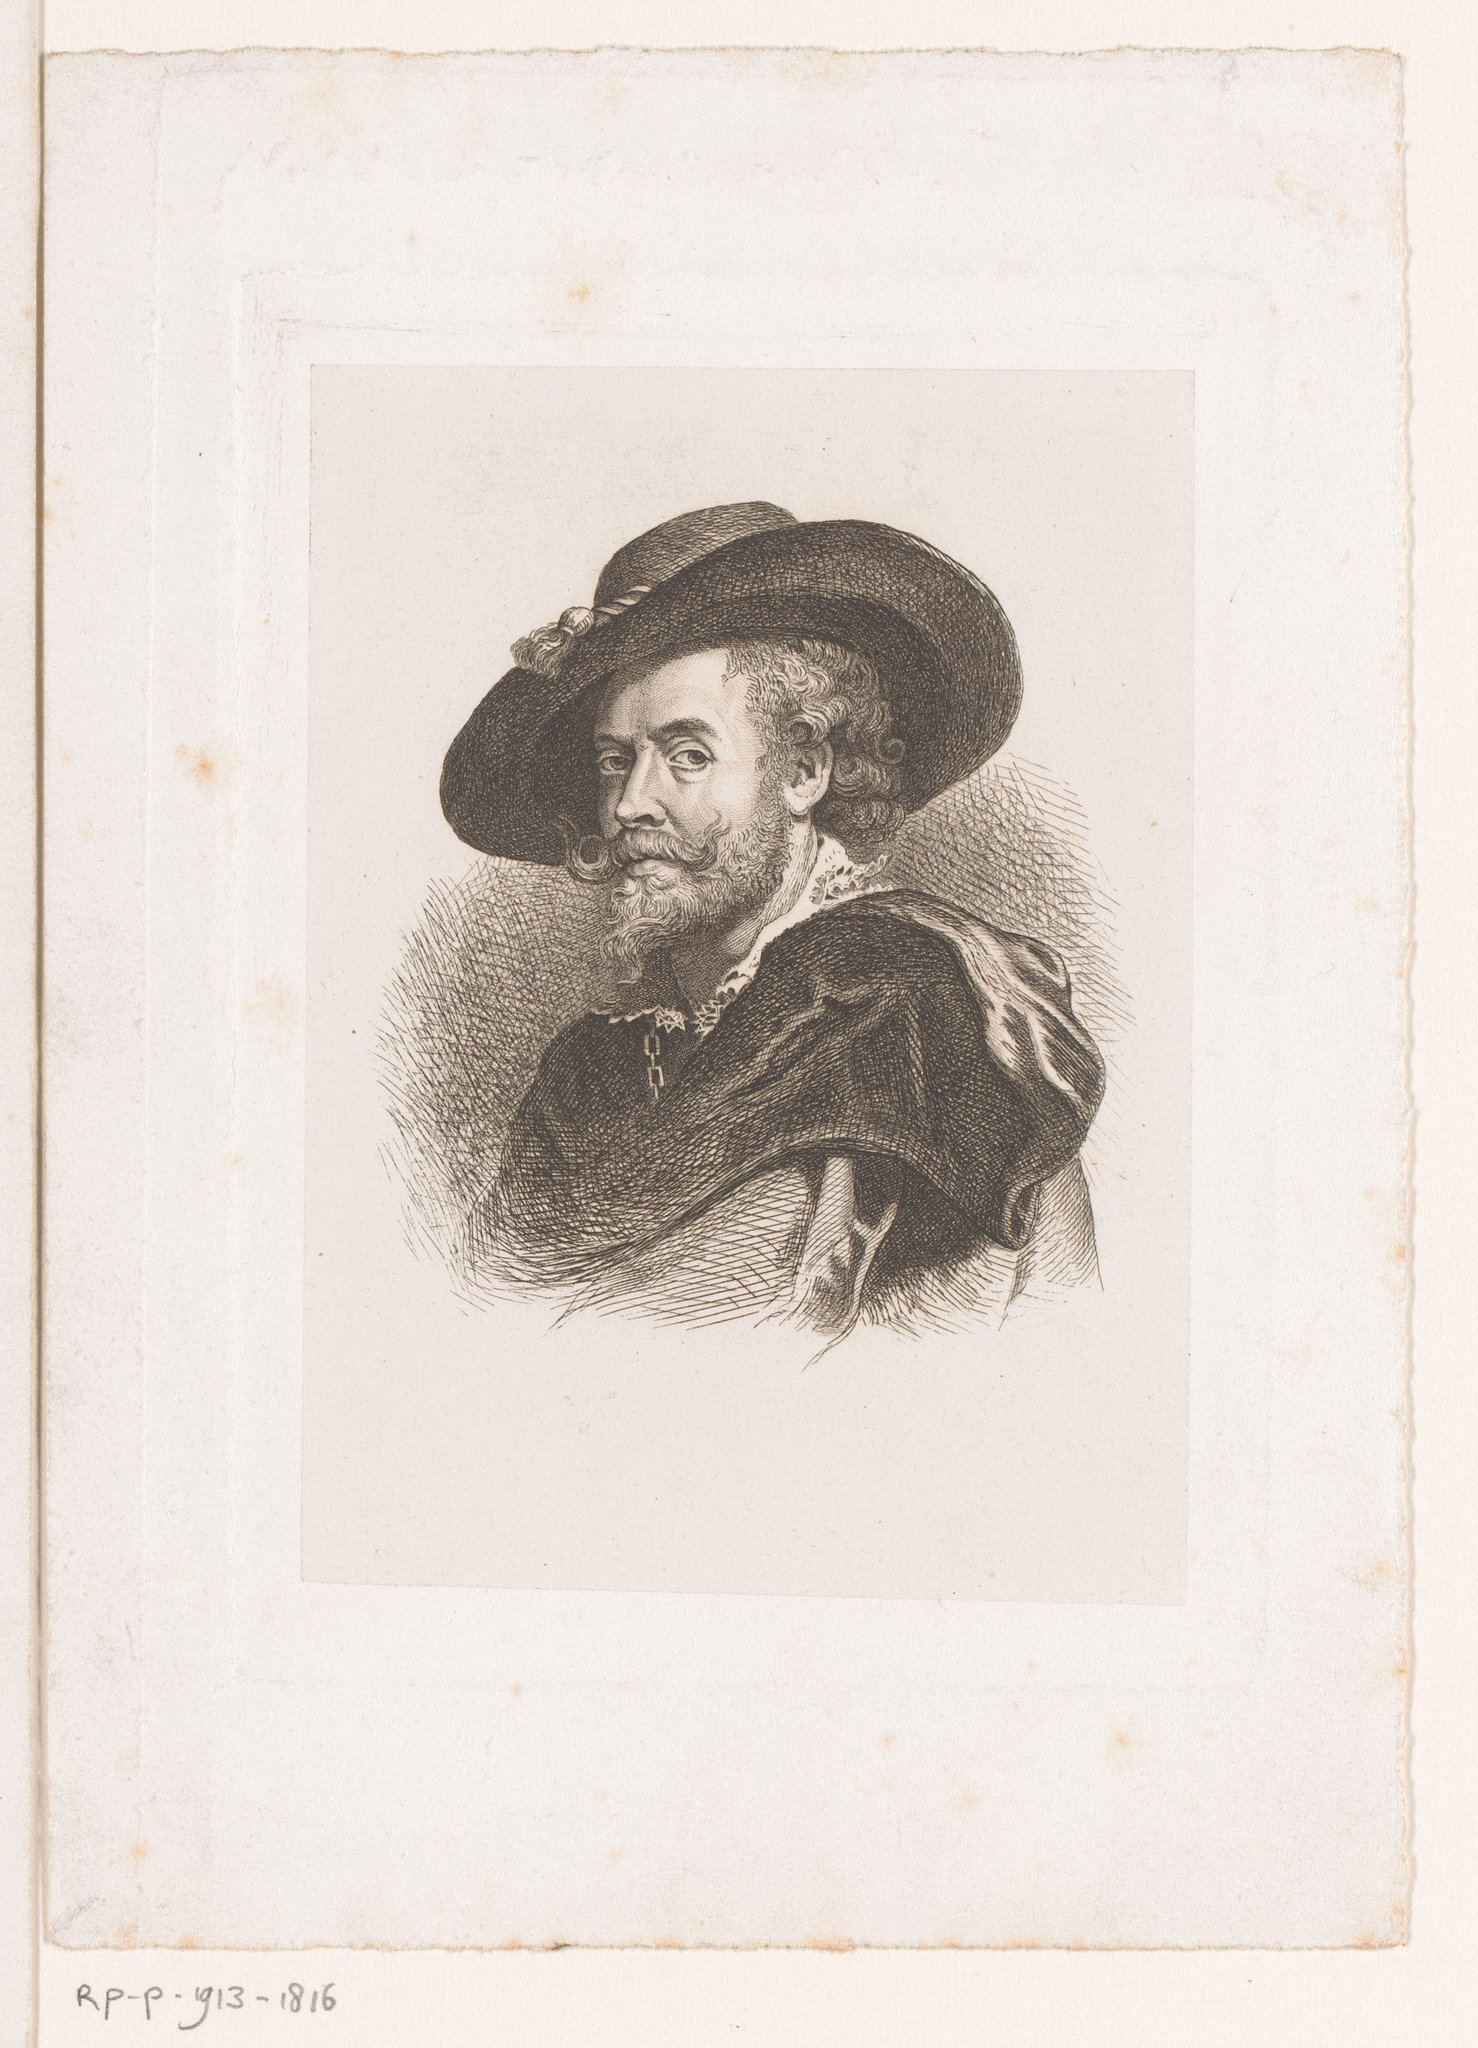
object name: print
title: Portret van Peter Paul Rubens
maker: jean baptiste pierre michiels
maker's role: print maker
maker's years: 1821-1890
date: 1831-1890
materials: paper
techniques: etching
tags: antwerp, painter, print maker, draughtsman, peter paul rubens, head-gear, adult man, historical persons, beard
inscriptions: collector's mark: Lugt 2228